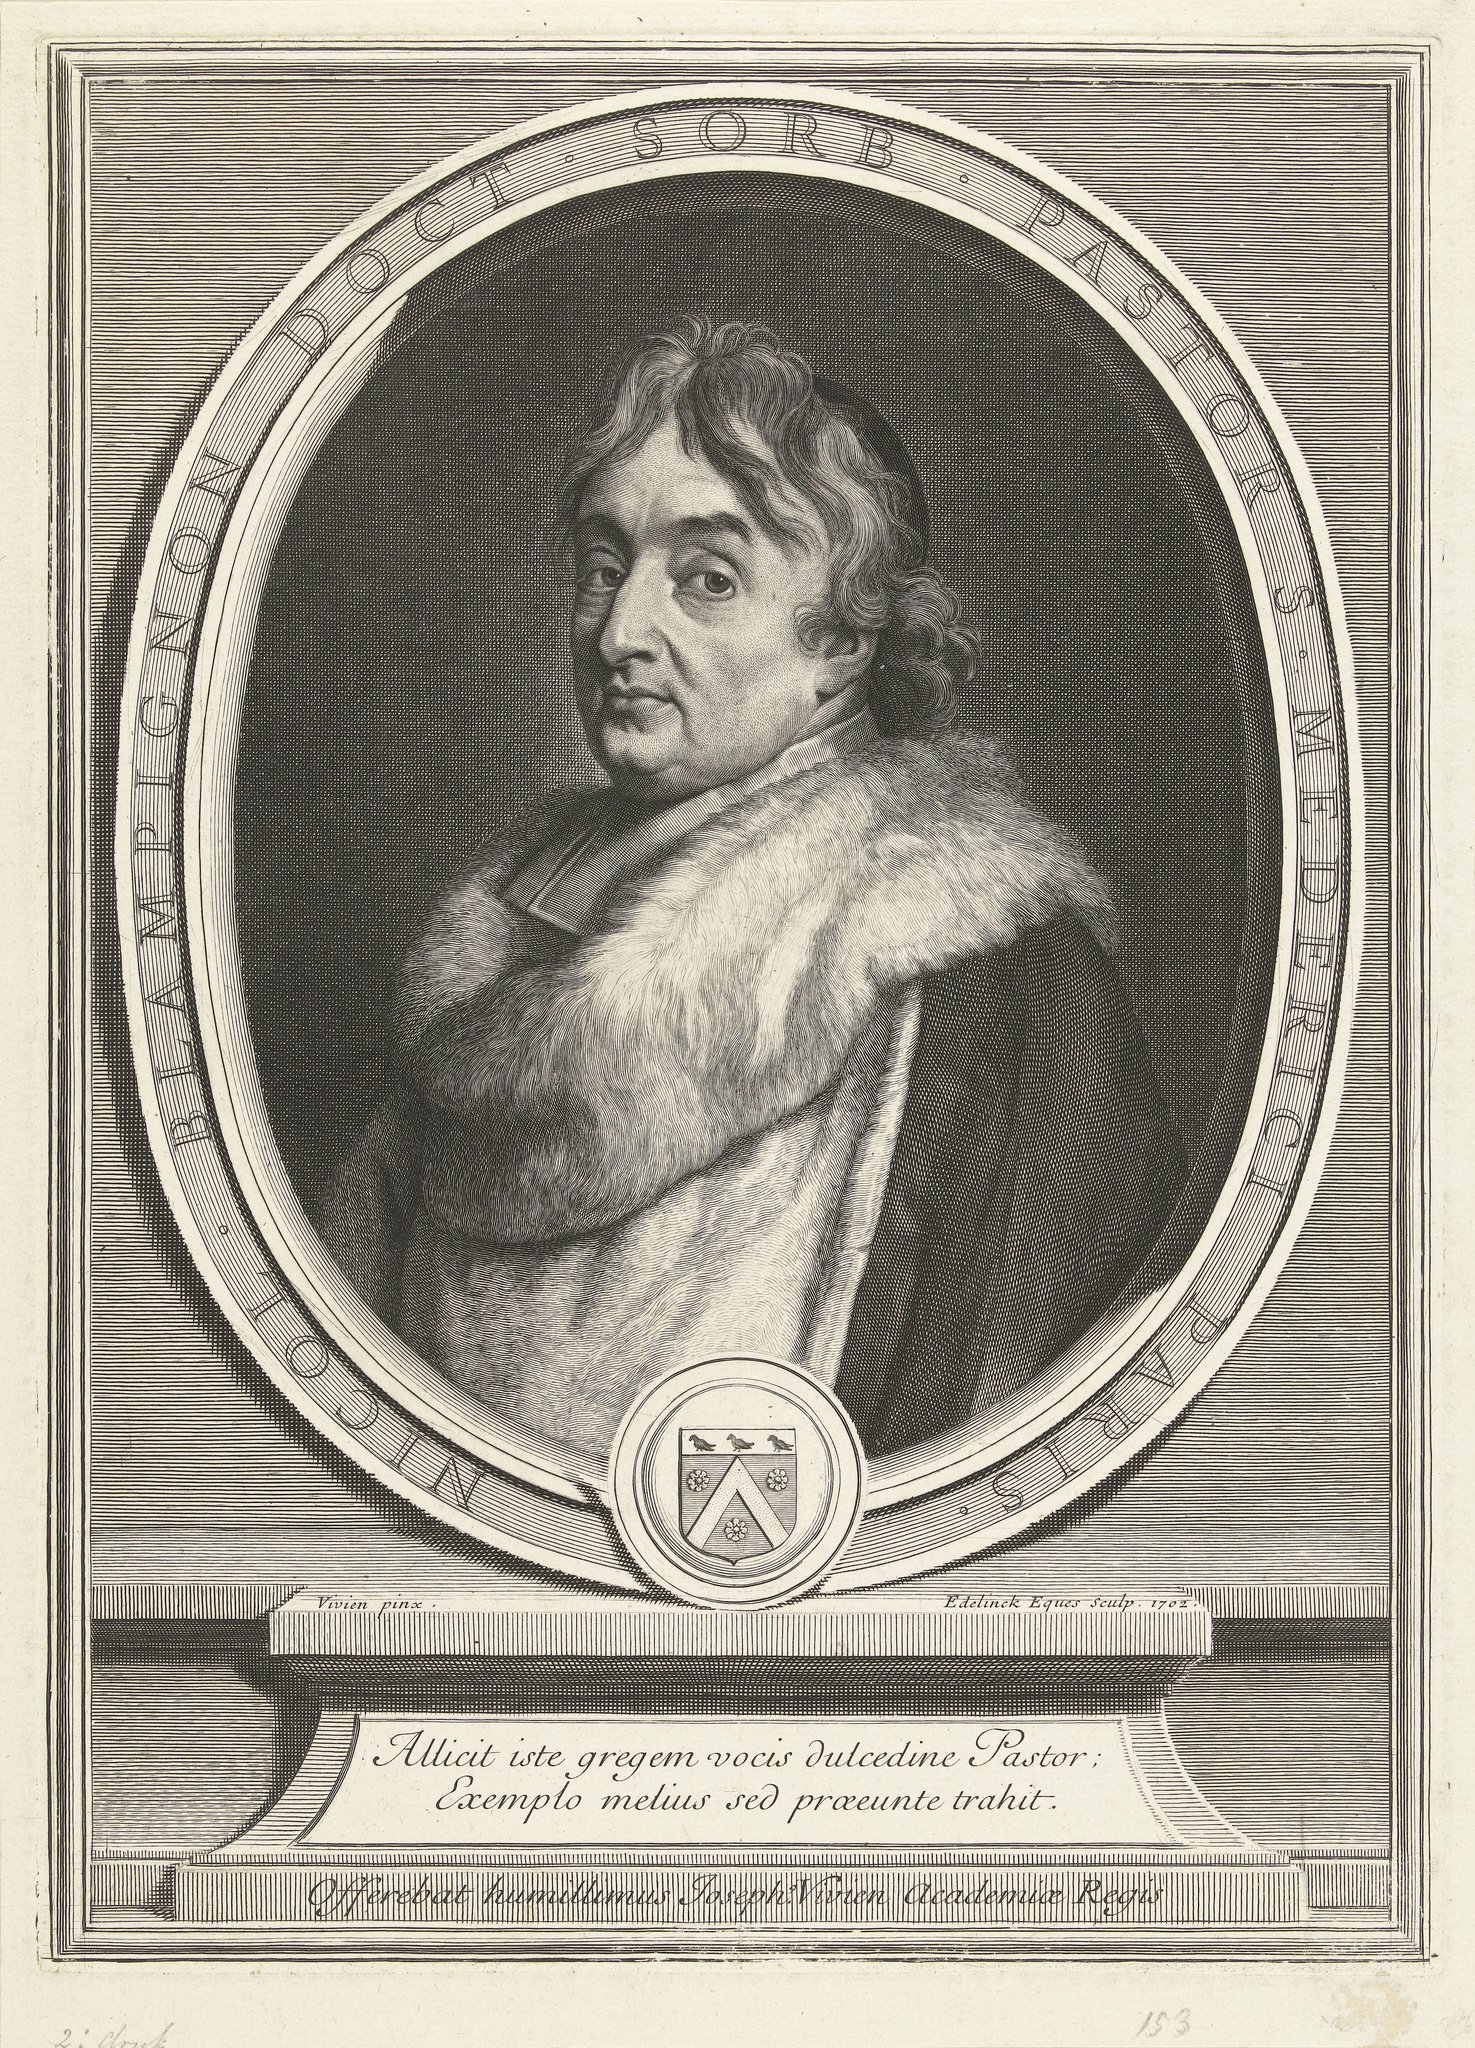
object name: print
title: Portret van Nicolas de Blampignon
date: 1702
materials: paper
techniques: engraving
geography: france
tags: pastoor, nicolas de blampignon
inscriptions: collector's mark: Lugt 240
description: Portret van Nicolas de Blampignon (1640-1710), pastoor van de Saint Merri in Parijs, afgebeeld in ovale omlijsting met wapen.